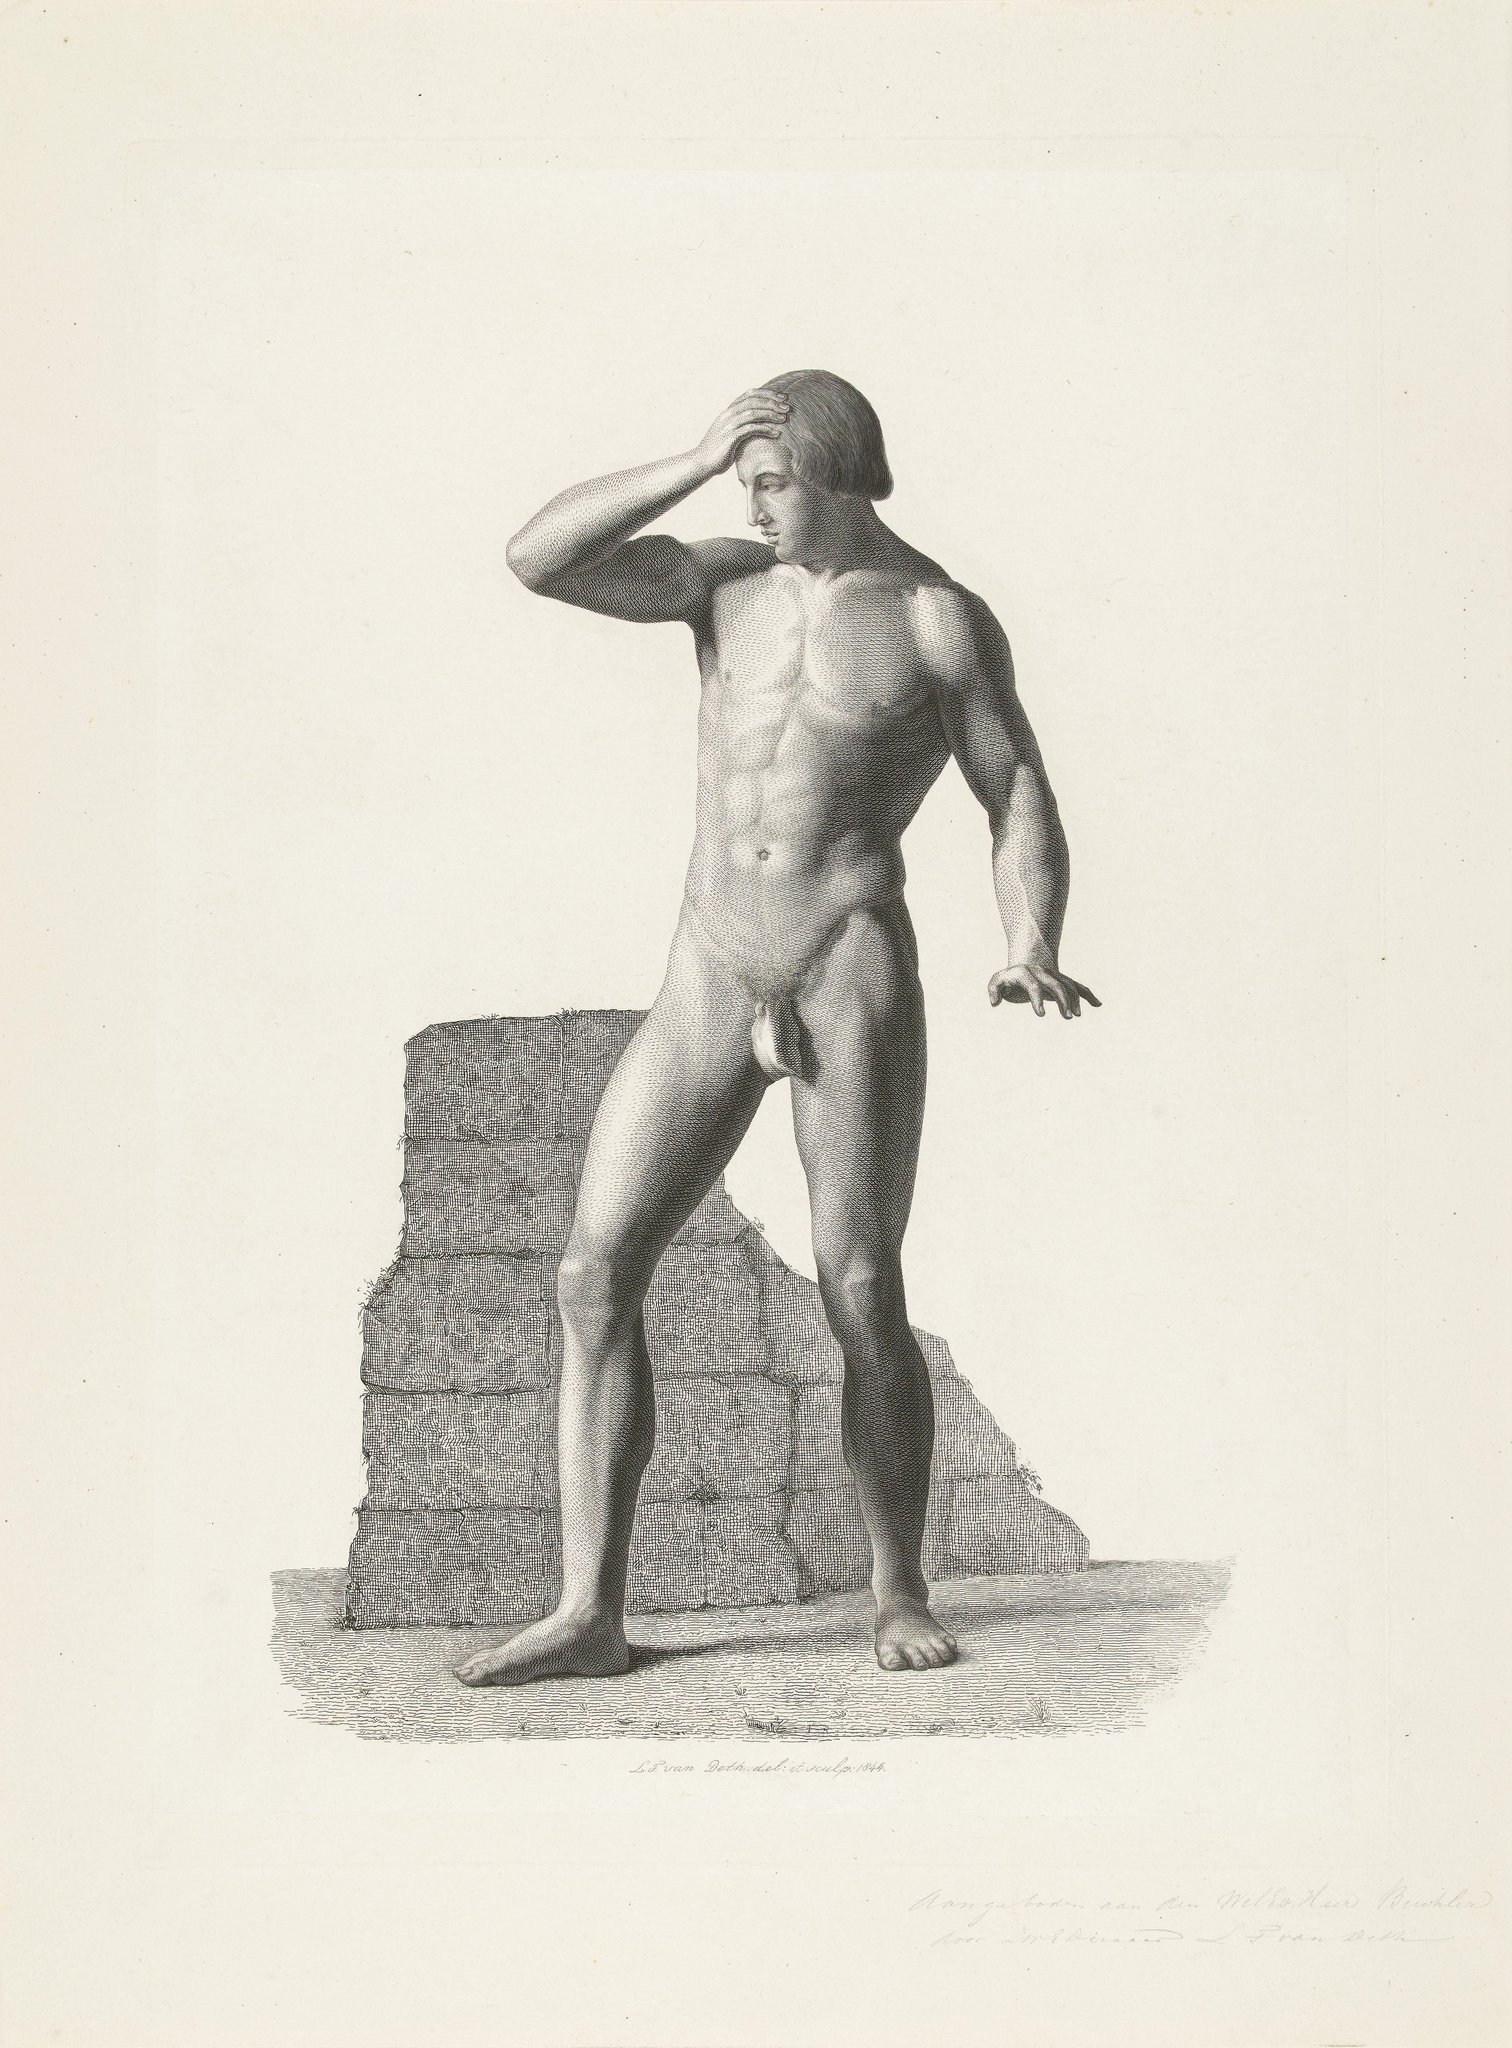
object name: print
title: Staand mannelijk naakt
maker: lubertus teunis van deth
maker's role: draughtsman, print maker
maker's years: 1814-1875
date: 1844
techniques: printmaking, engraving, etching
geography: netherlands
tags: human figure of ideal proportions, e.g. academic nude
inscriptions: collector's mark: Lugt 2228, inscription: ‘Aangeboden aan den Weled. Heer Buchler door Zn E Dienaar L.T van Deth’